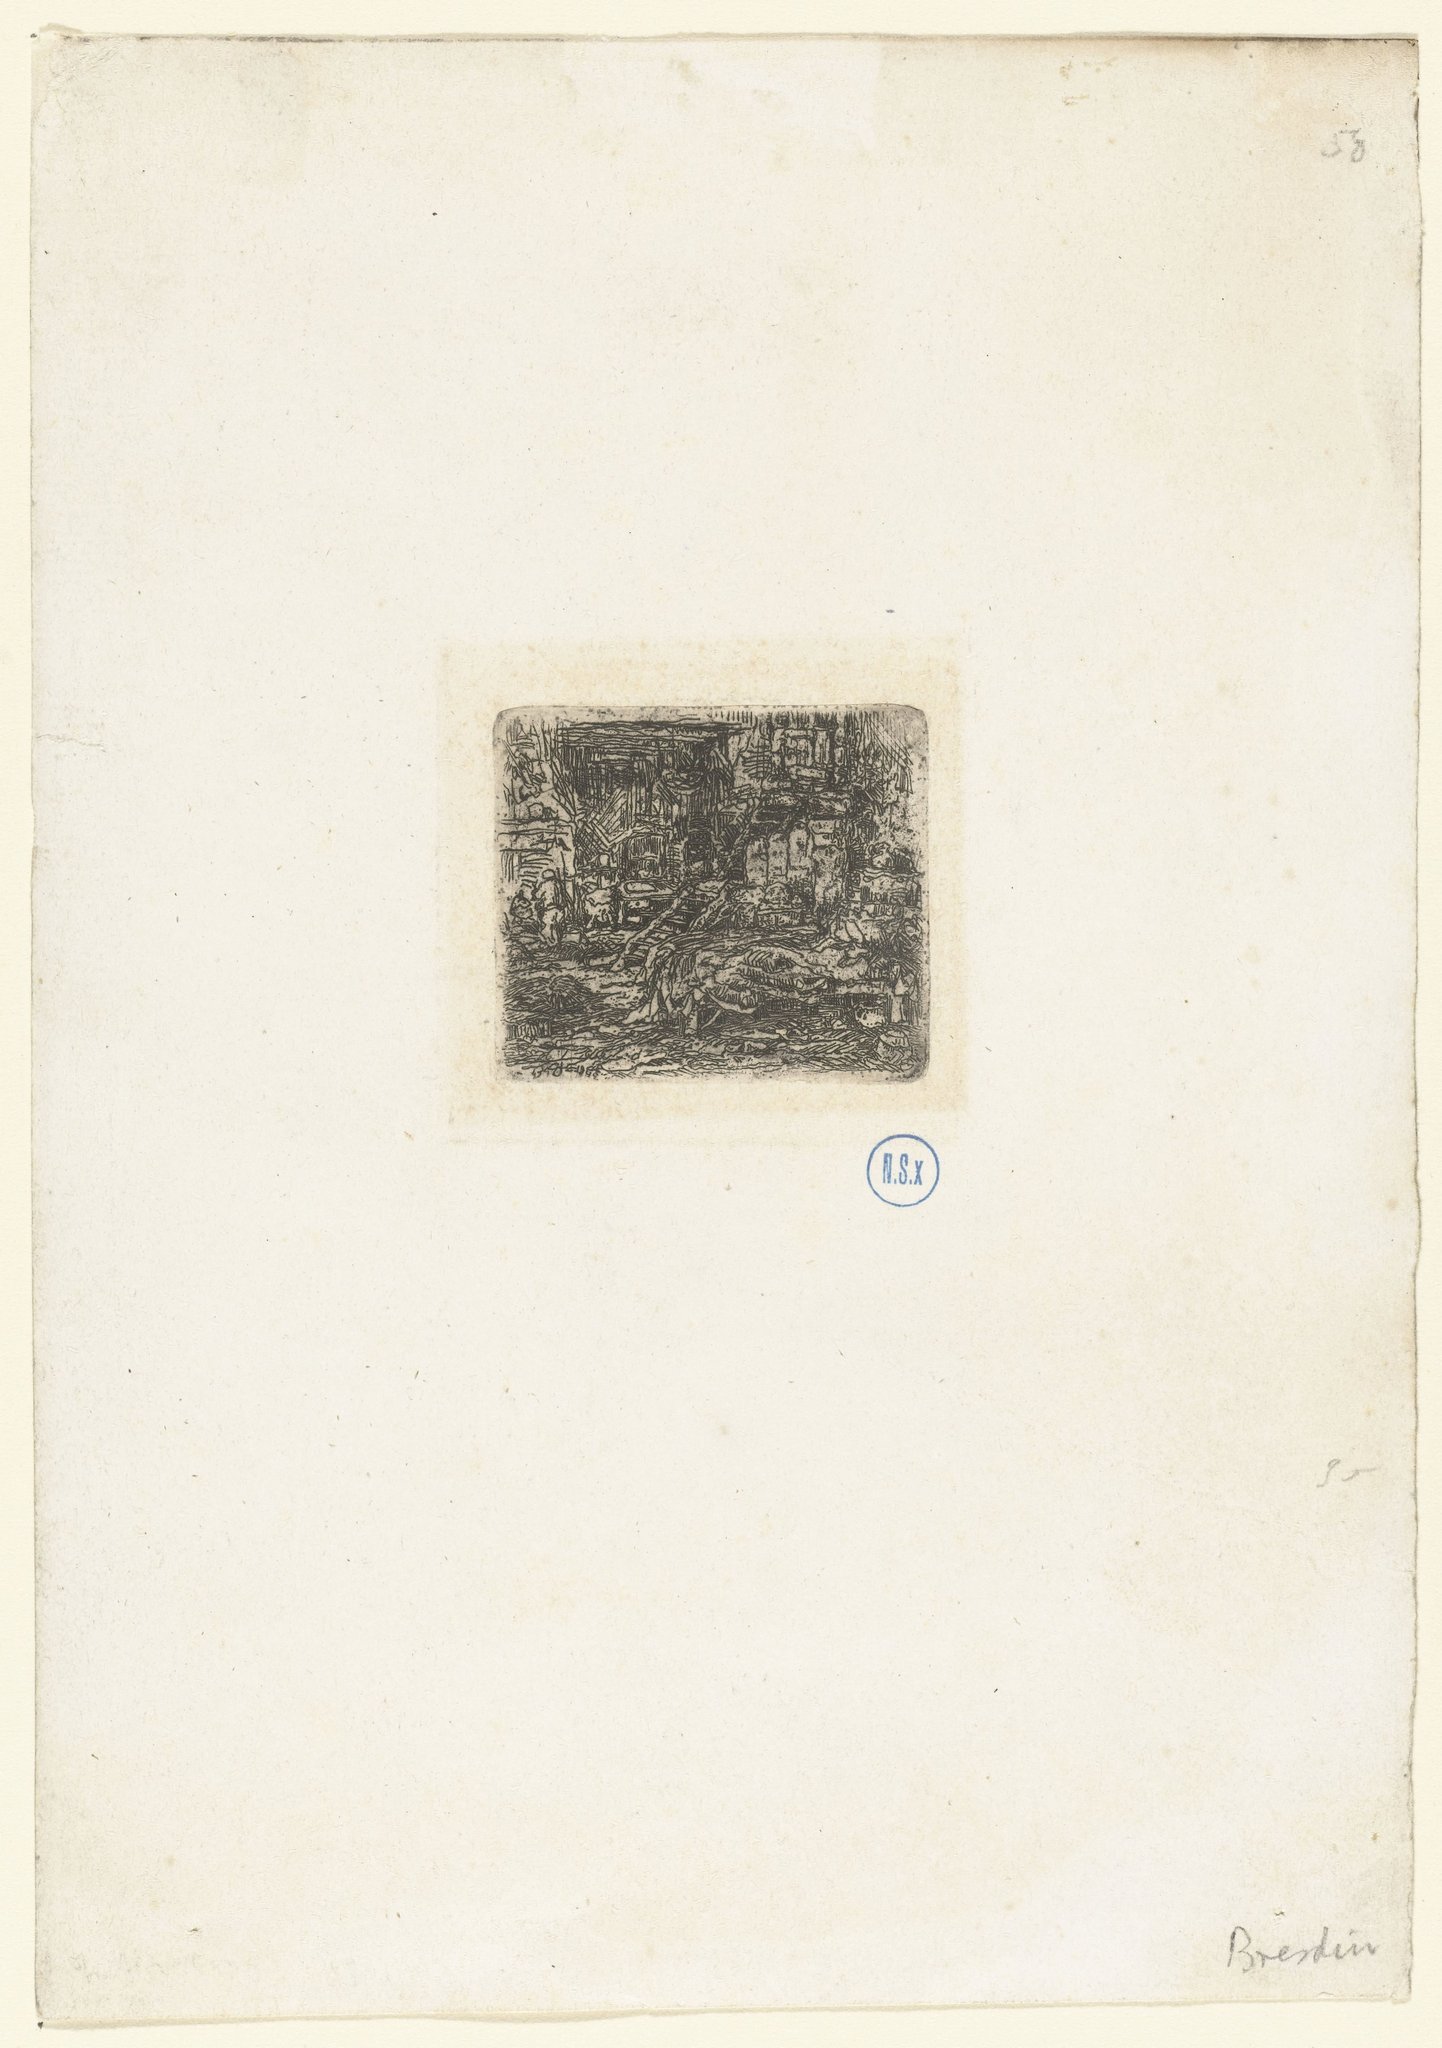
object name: print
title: Interieur van boerderij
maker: rodolphe bresdin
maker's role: draughtsman, print maker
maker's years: 1822-1885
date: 1843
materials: paper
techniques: etching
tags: interior of the house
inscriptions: collector's mark: Lugt 2228, collector's mark: Lugt 1989a, collector's mark: Lugt 2760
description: Herkomst Collectie Nicolaas Sax, Amsterdam